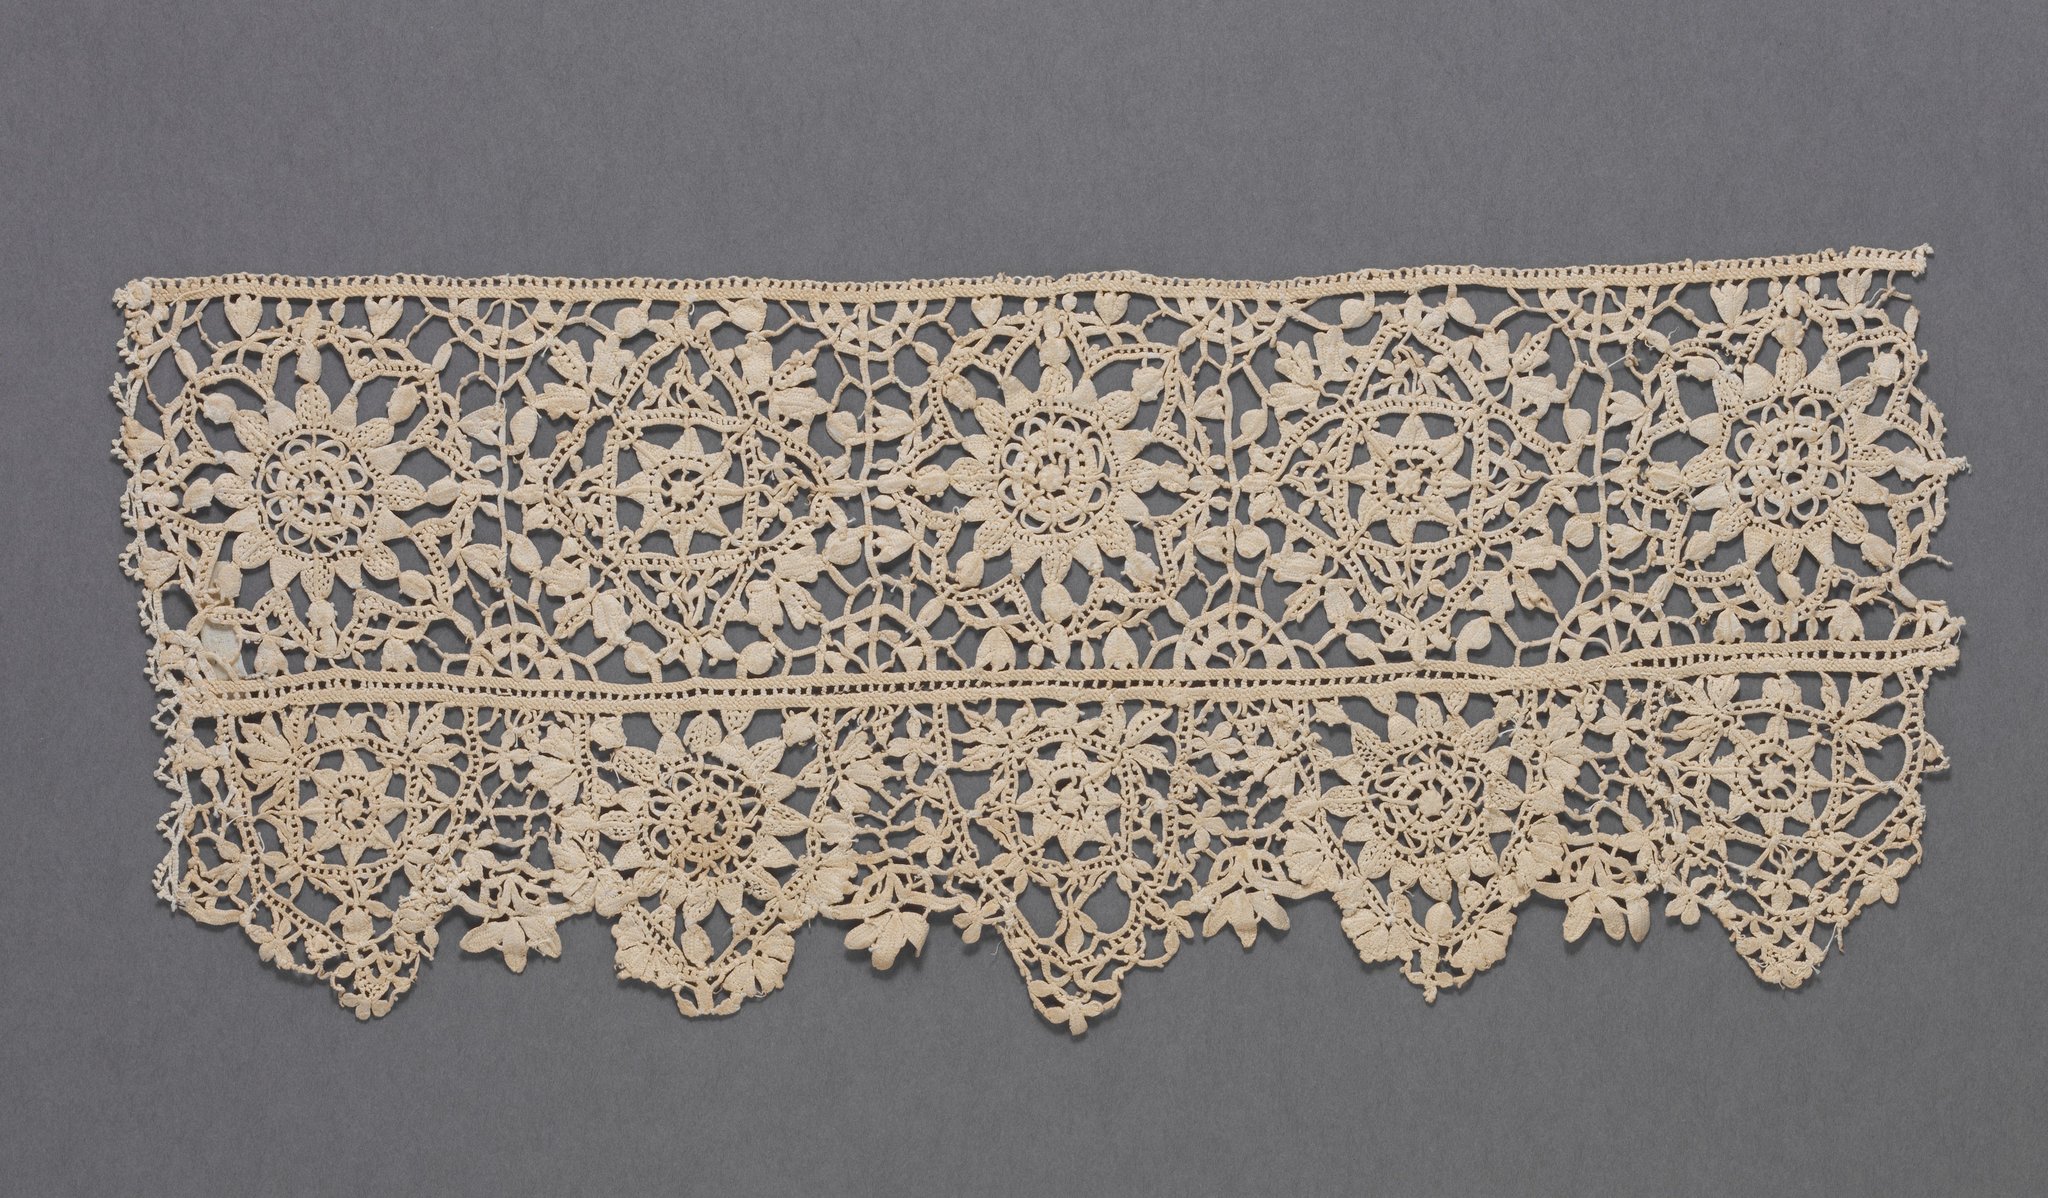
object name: border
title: Border (five points)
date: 1600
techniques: lace